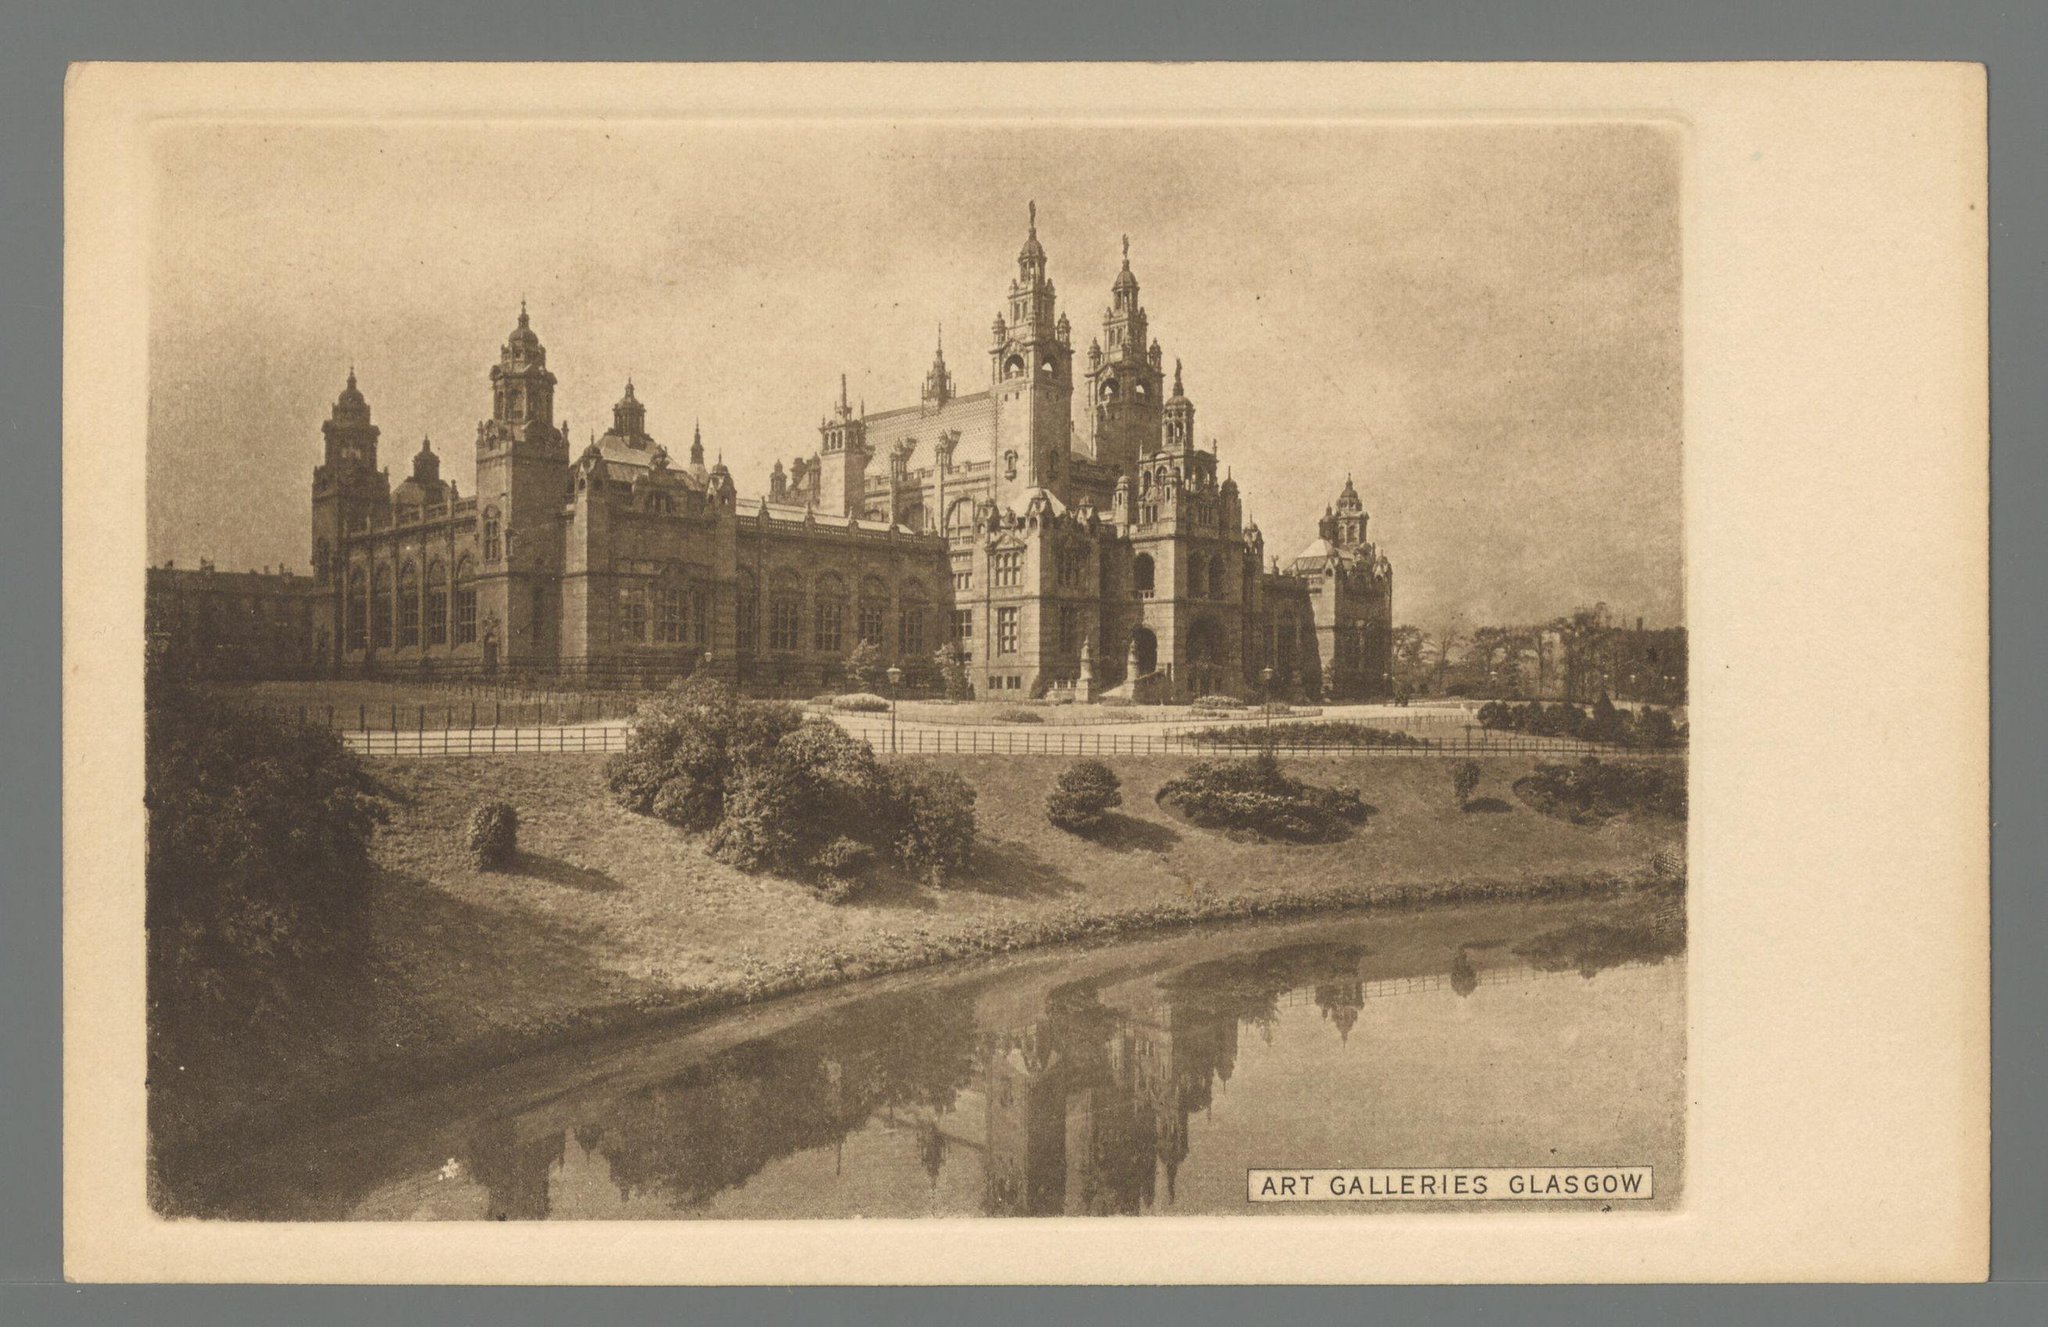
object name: ansichtkaart, prentbriefkaart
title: Art Galleries Glasgow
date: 1894-1905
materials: cardboard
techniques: photoaquatint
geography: glasgow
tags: permanent exhibition, museum, glasgow